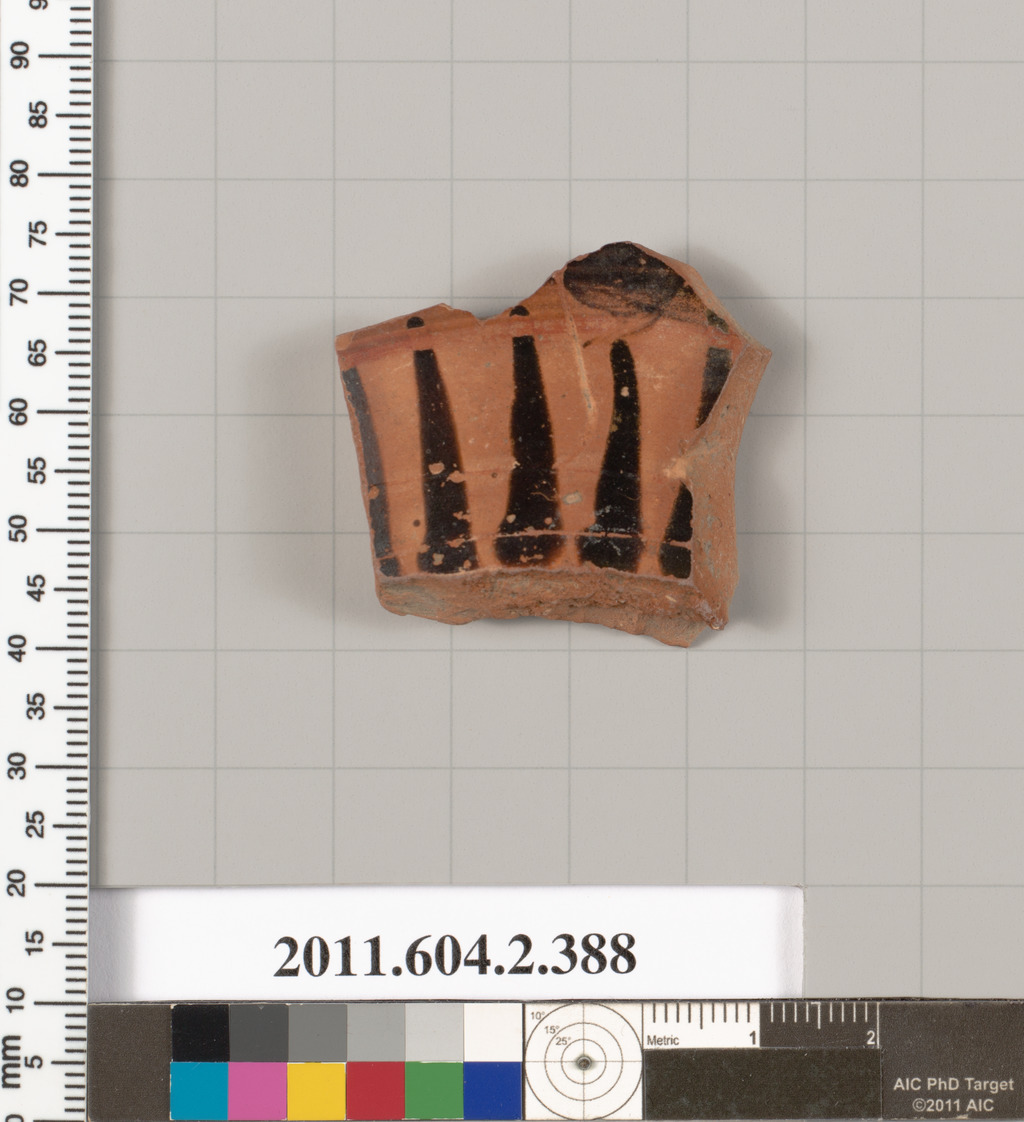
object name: column krater fragment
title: Terracotta fragment of a column-krater (bowl for mixing wine and water)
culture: greek, attic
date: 450-430 BCE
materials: terracotta